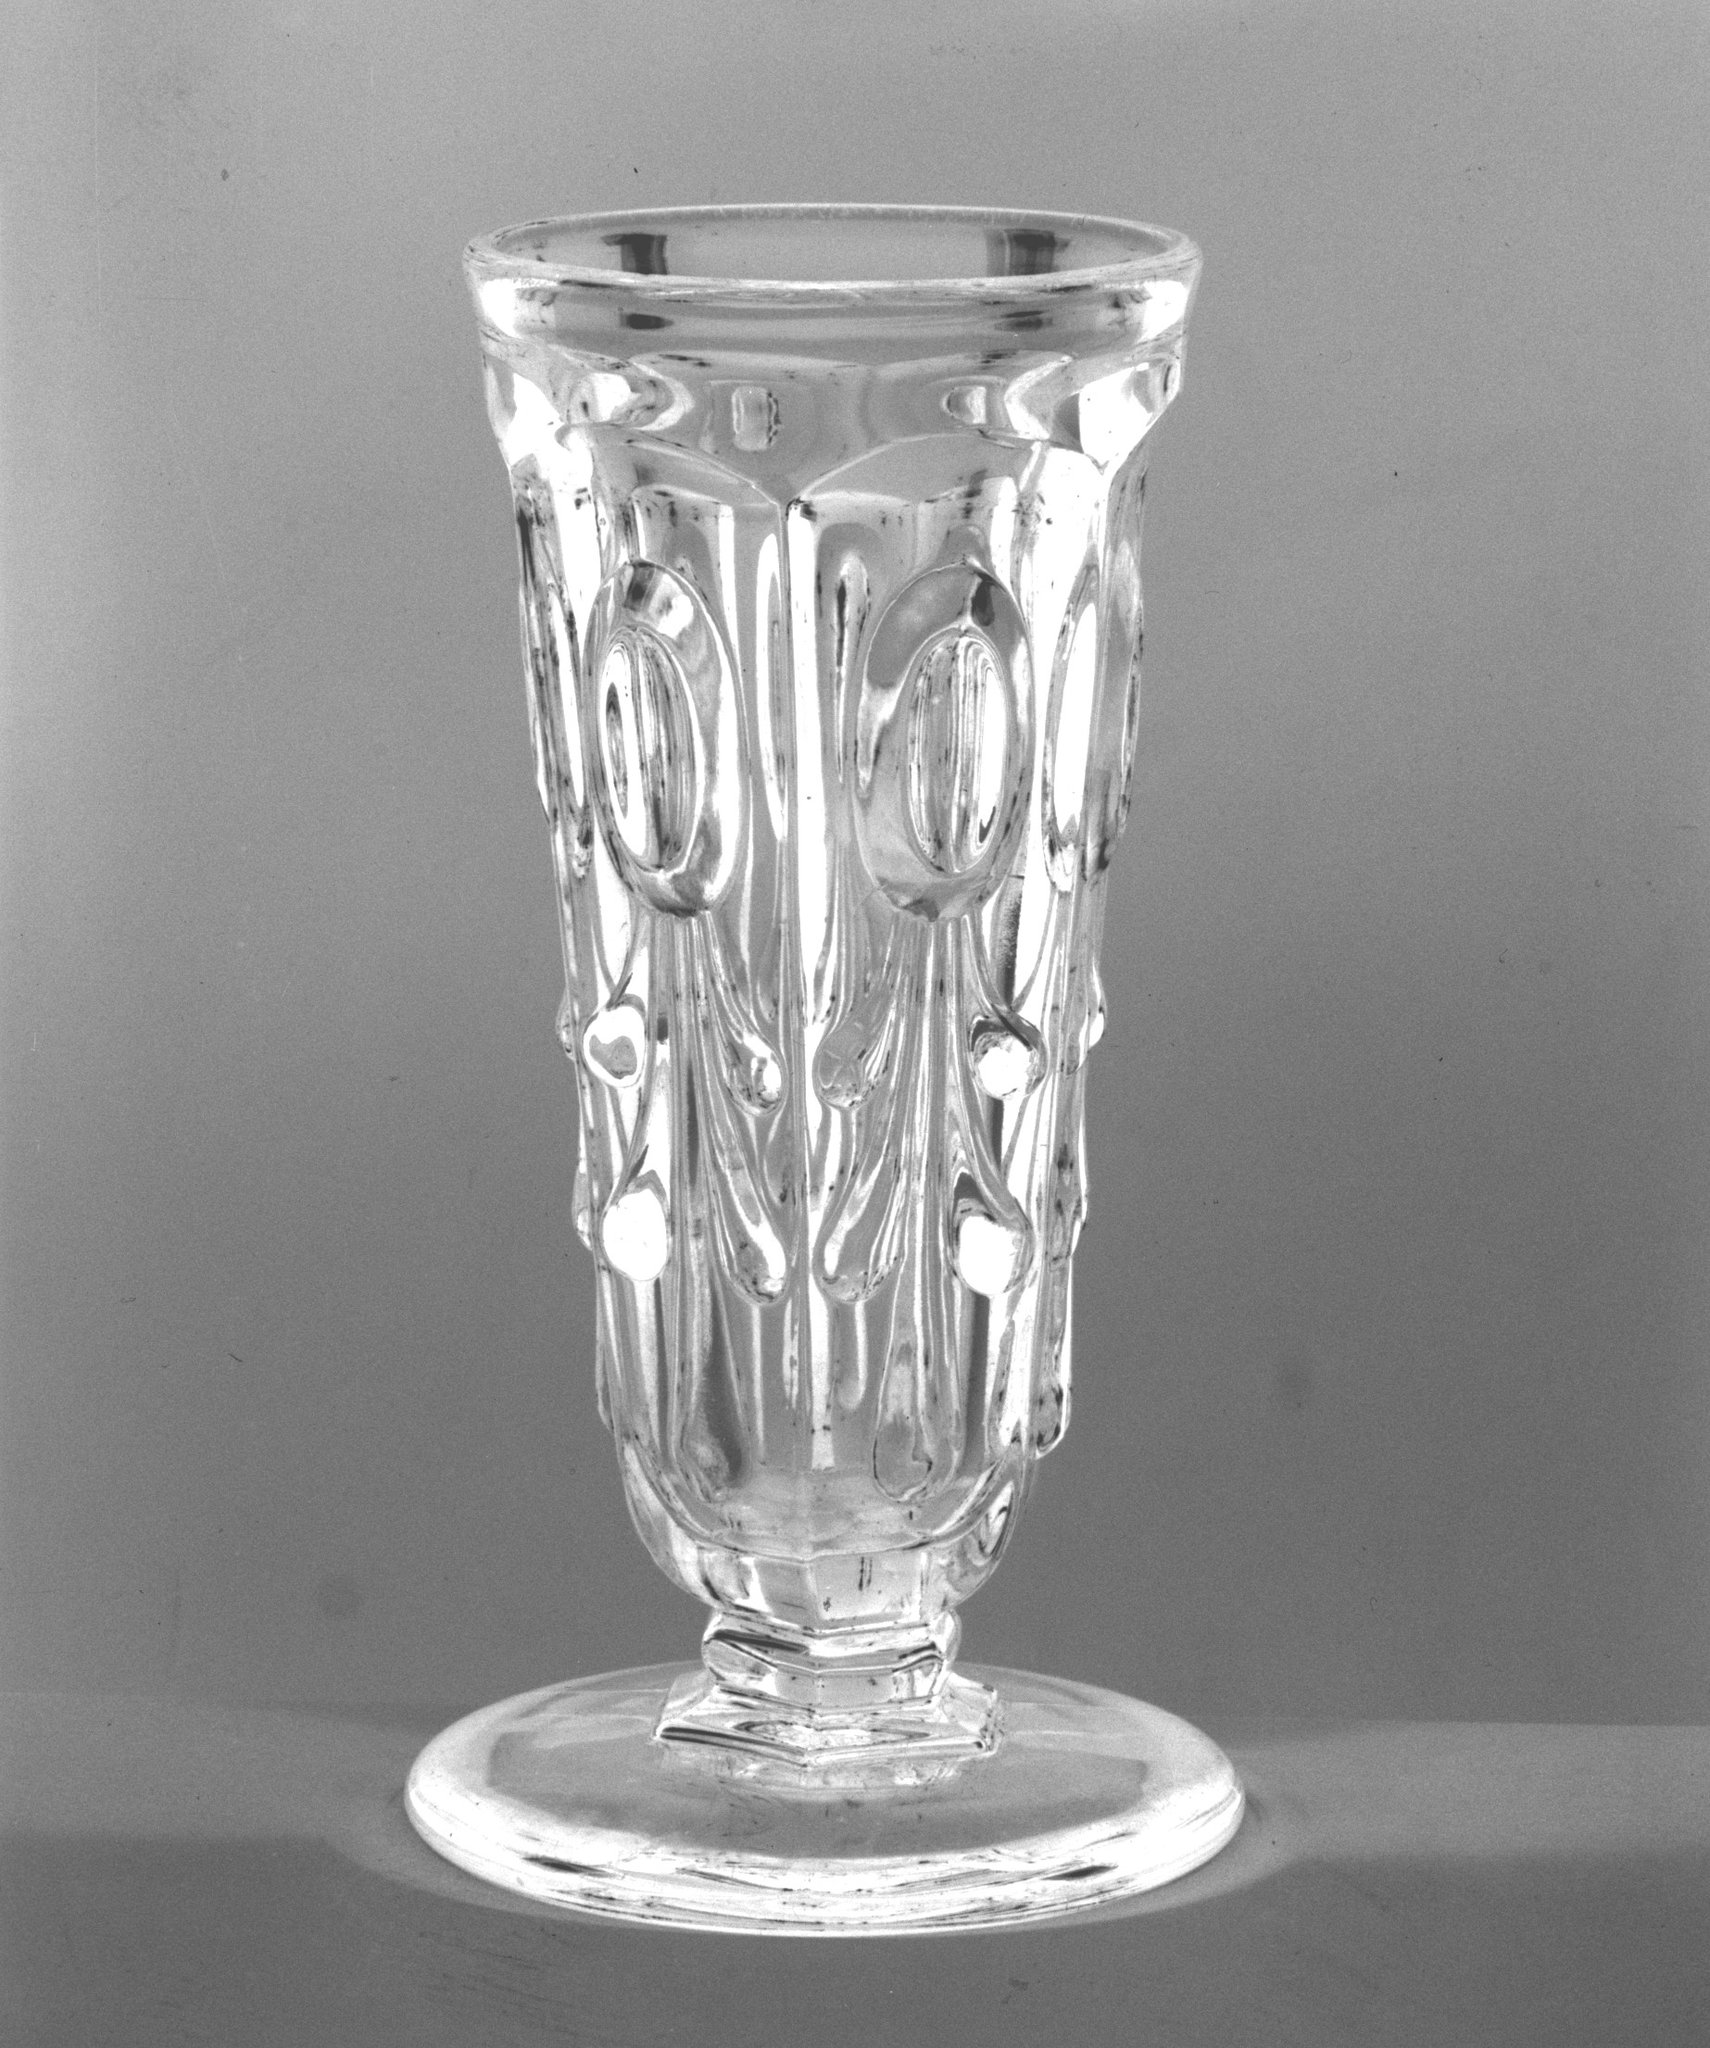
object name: ale glass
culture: american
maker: union glass company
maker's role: maker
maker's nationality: american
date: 1850-1870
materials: glass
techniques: pressed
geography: united states